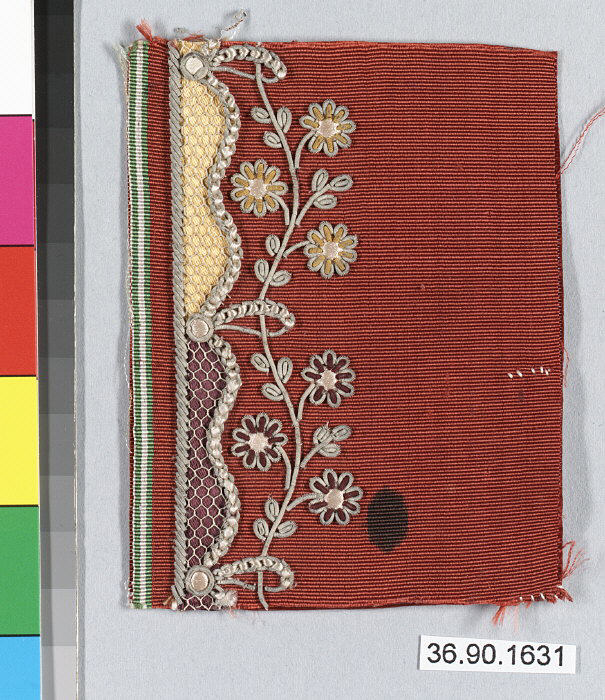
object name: sample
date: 1801-1833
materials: metal thread, silk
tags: flowers